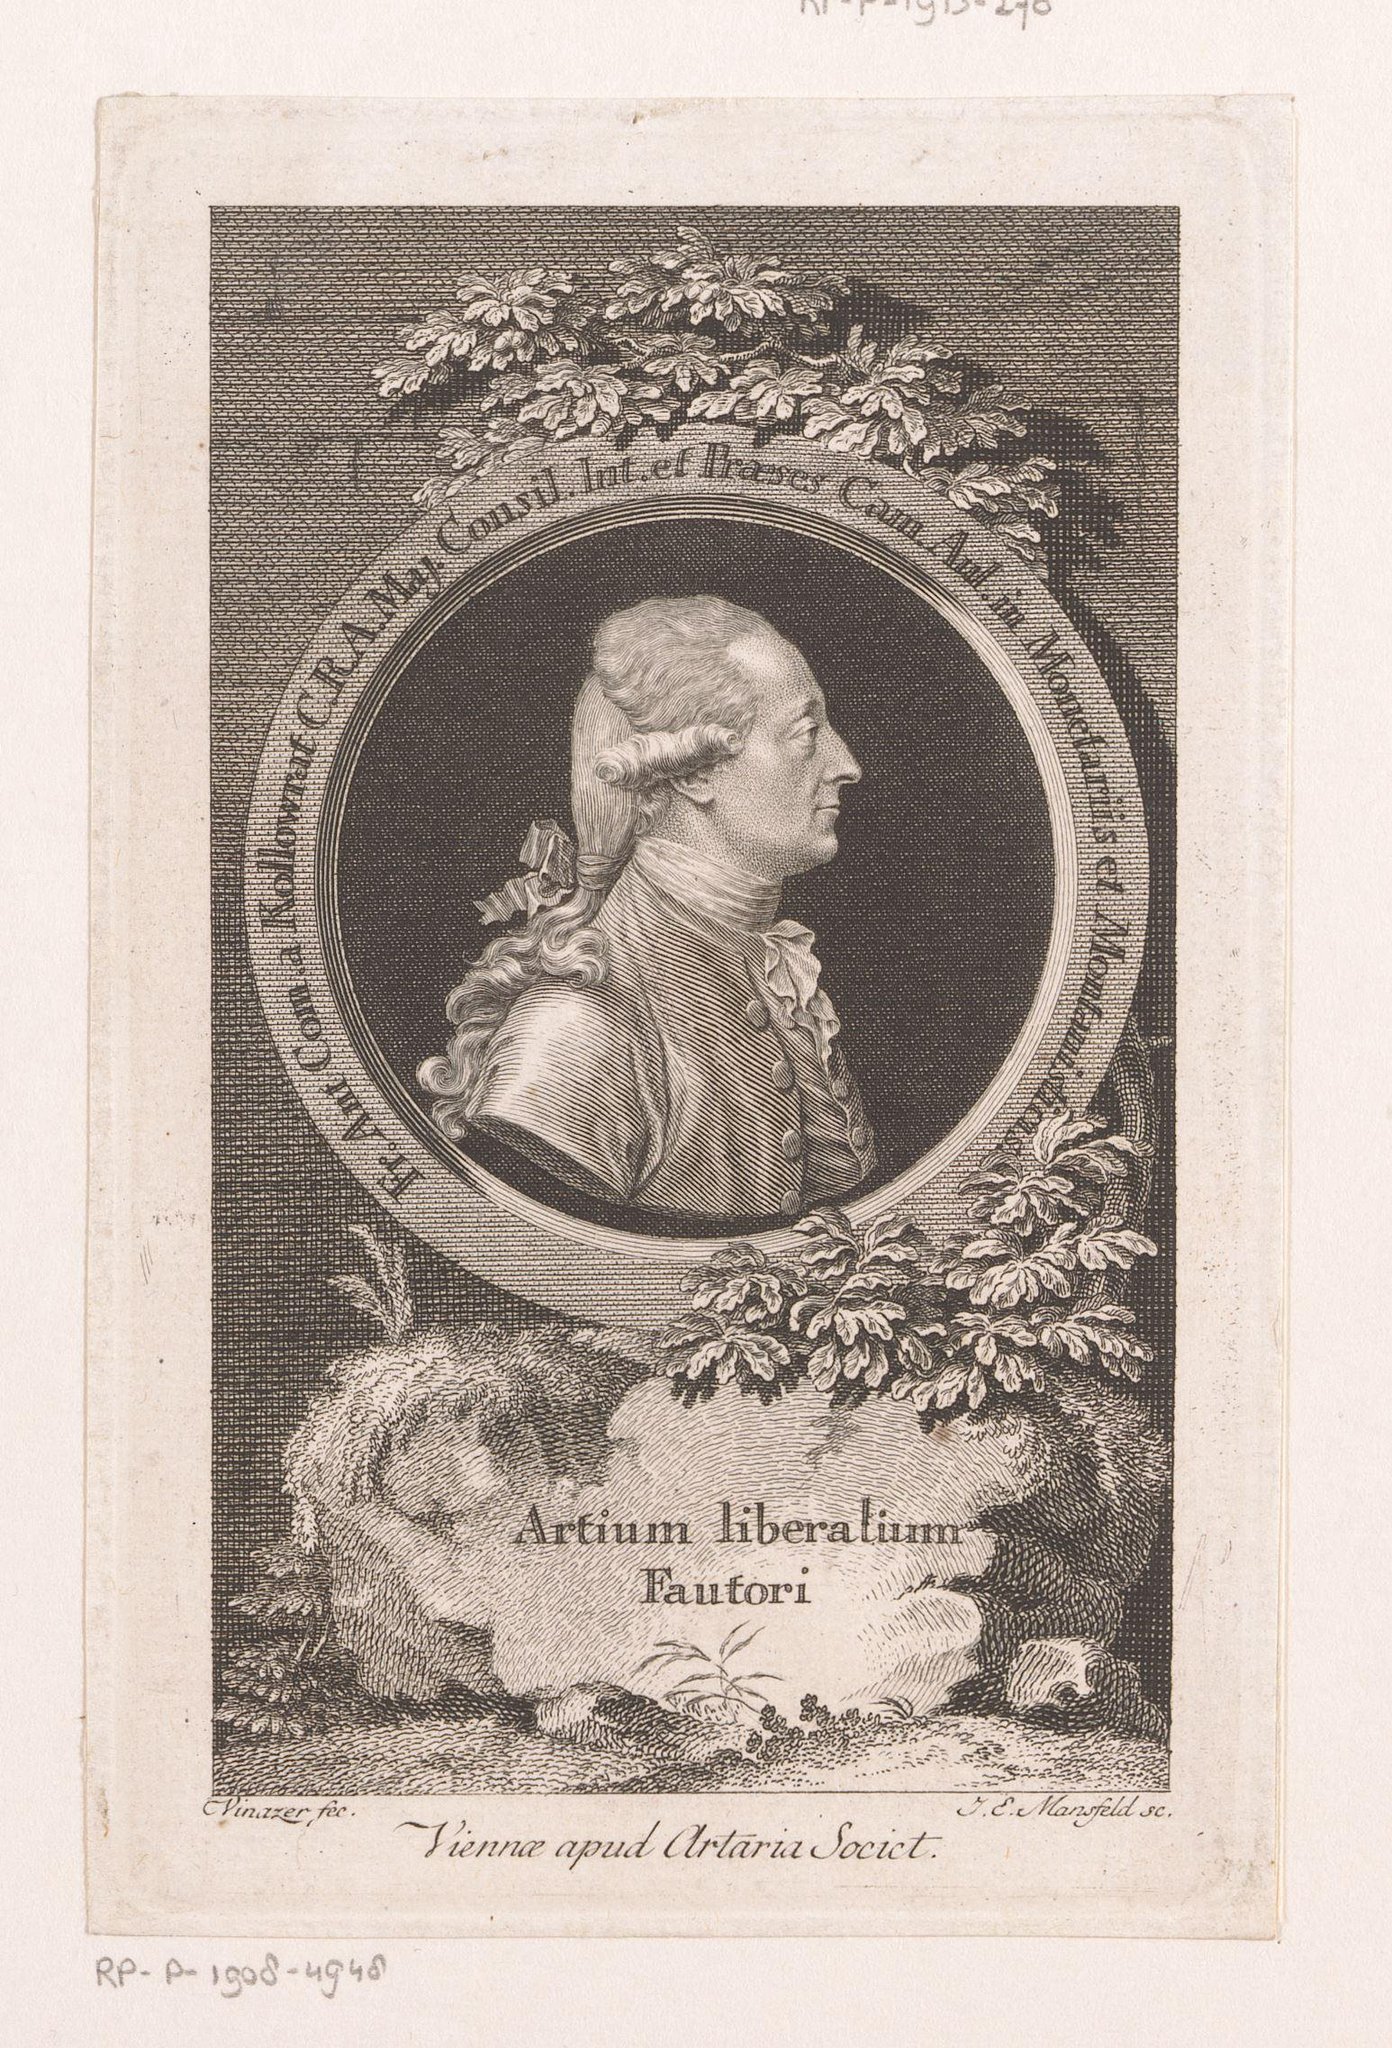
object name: print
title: Portret van Franz Anton, Graf von Kolowrat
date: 1749-1796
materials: paper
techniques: engraving, etching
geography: vienna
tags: prague, historical persons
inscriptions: collector's mark: Lugt 2228